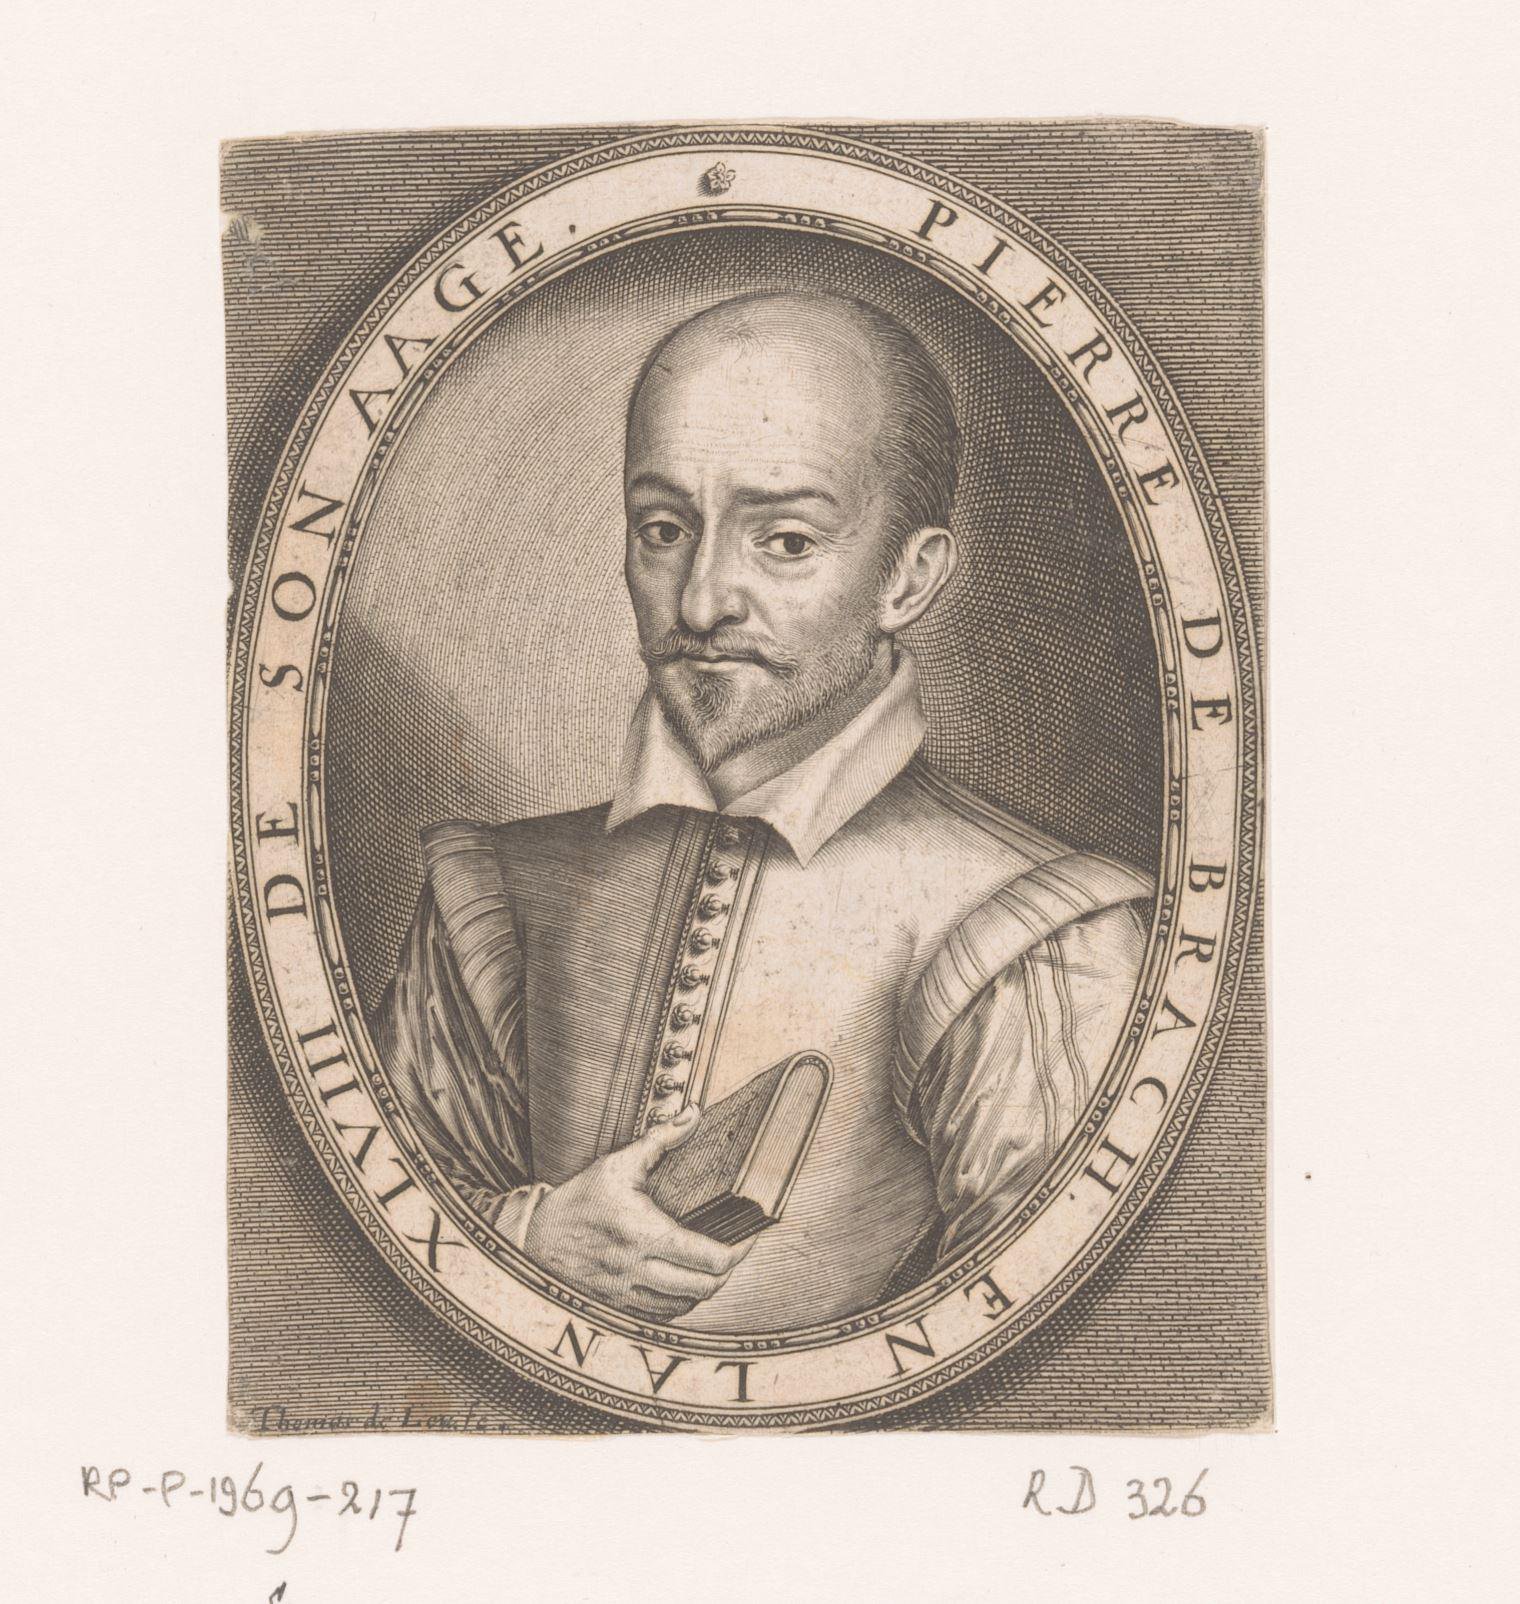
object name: print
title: Portret van Pierre de Brach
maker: thomas de leu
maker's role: print maker, publisher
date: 1576-1614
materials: paper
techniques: engraving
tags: historical persons, portrait of a writer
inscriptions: collector's mark: Lugt 2228